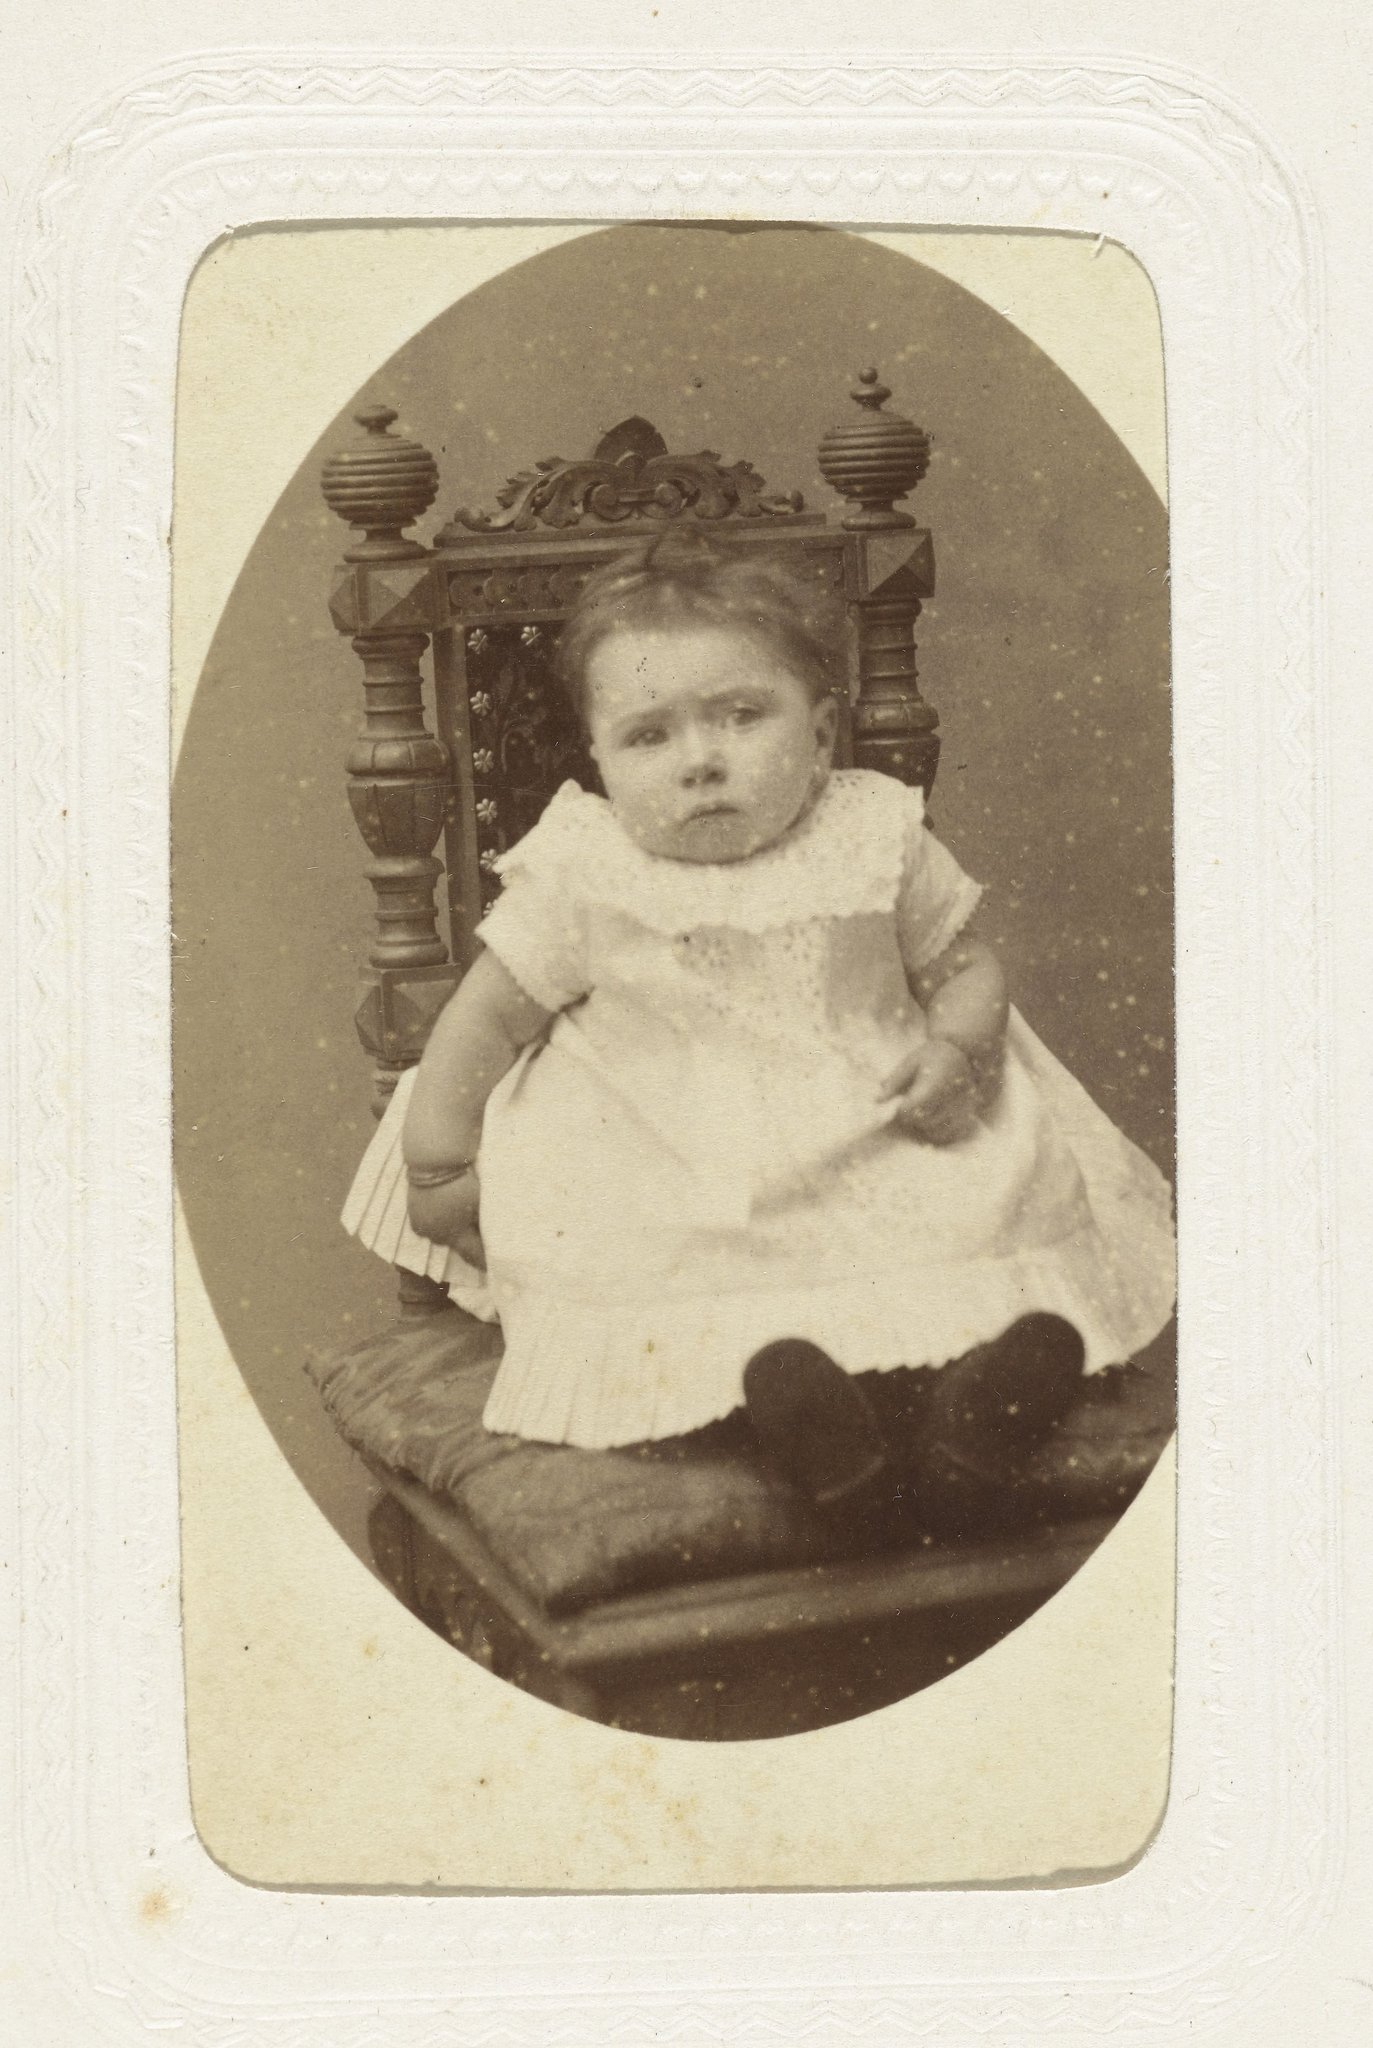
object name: carte de visite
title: Studioportret van een baby in een witte jurk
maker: j.h. v.d. heijden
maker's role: fotograaf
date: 1863-1866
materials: cardboard, paper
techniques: albumen print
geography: amsterdam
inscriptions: name: ‘Albert Greiner, Amsterdam’